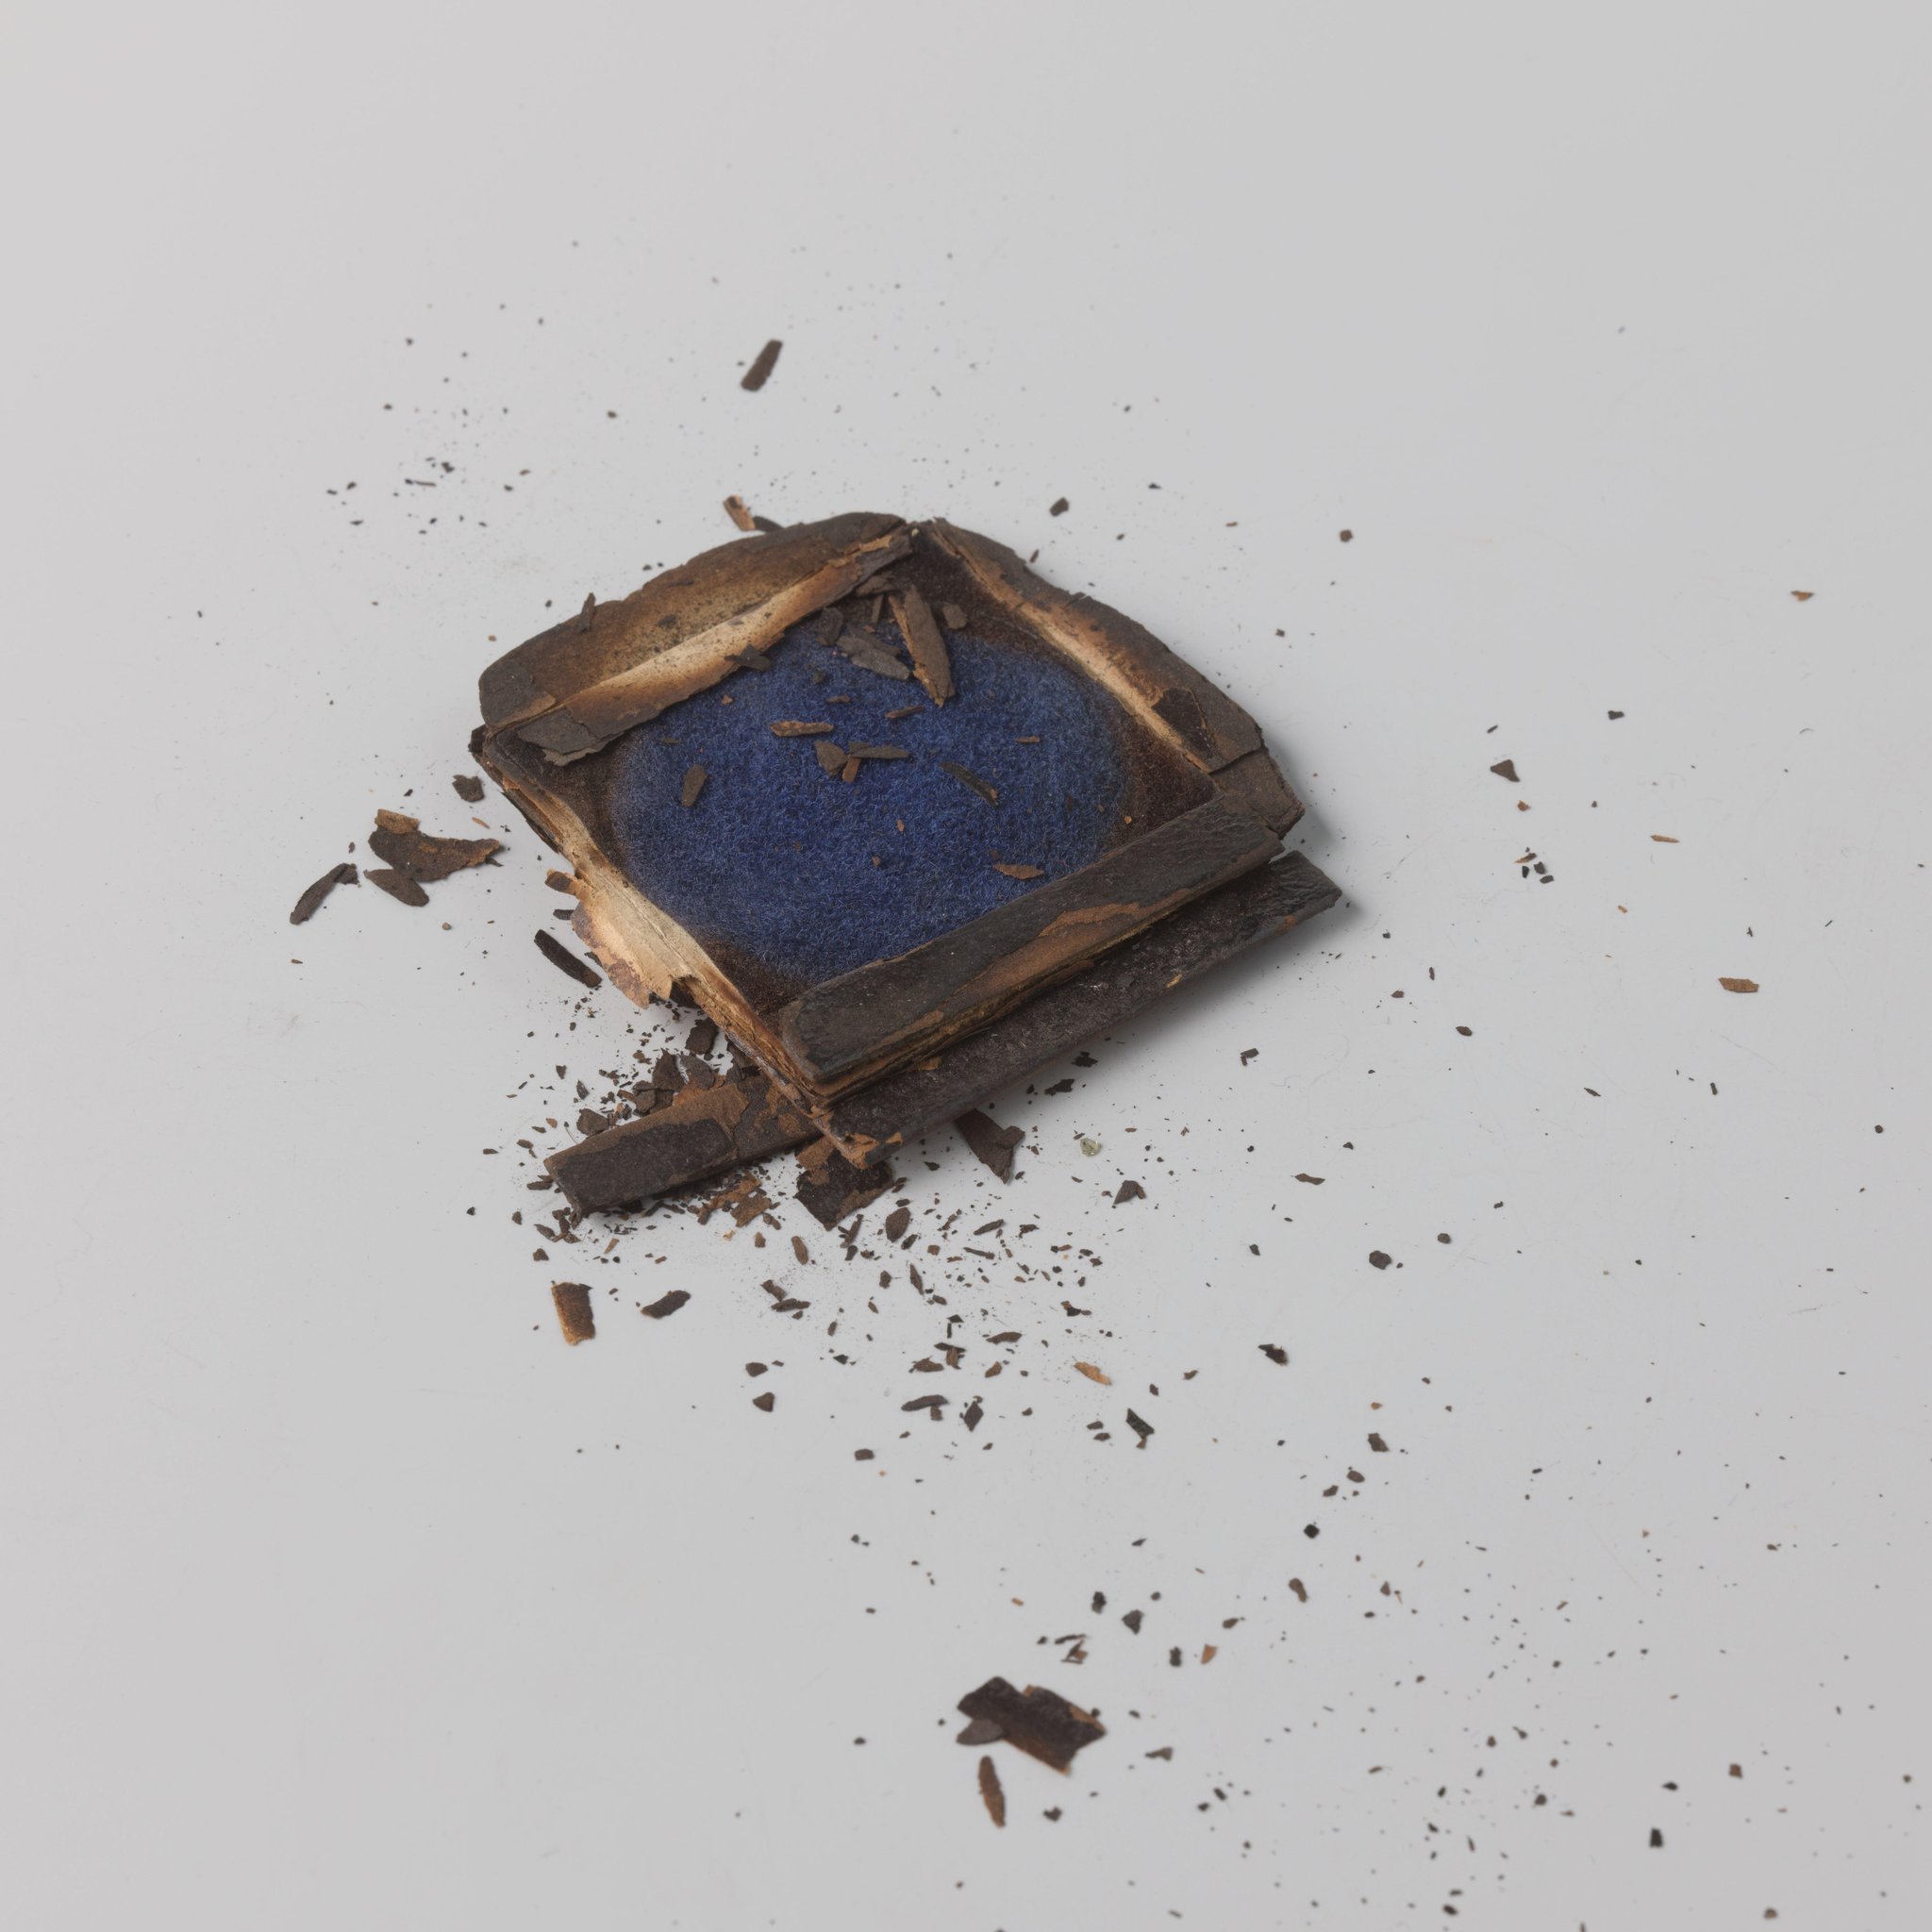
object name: medal box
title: Penningdoos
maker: Anonymous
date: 1986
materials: paper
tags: dutch east indies, the, amsterdam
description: Half verbrande doos. Met bijbehorende penning NG-1988-22-1.